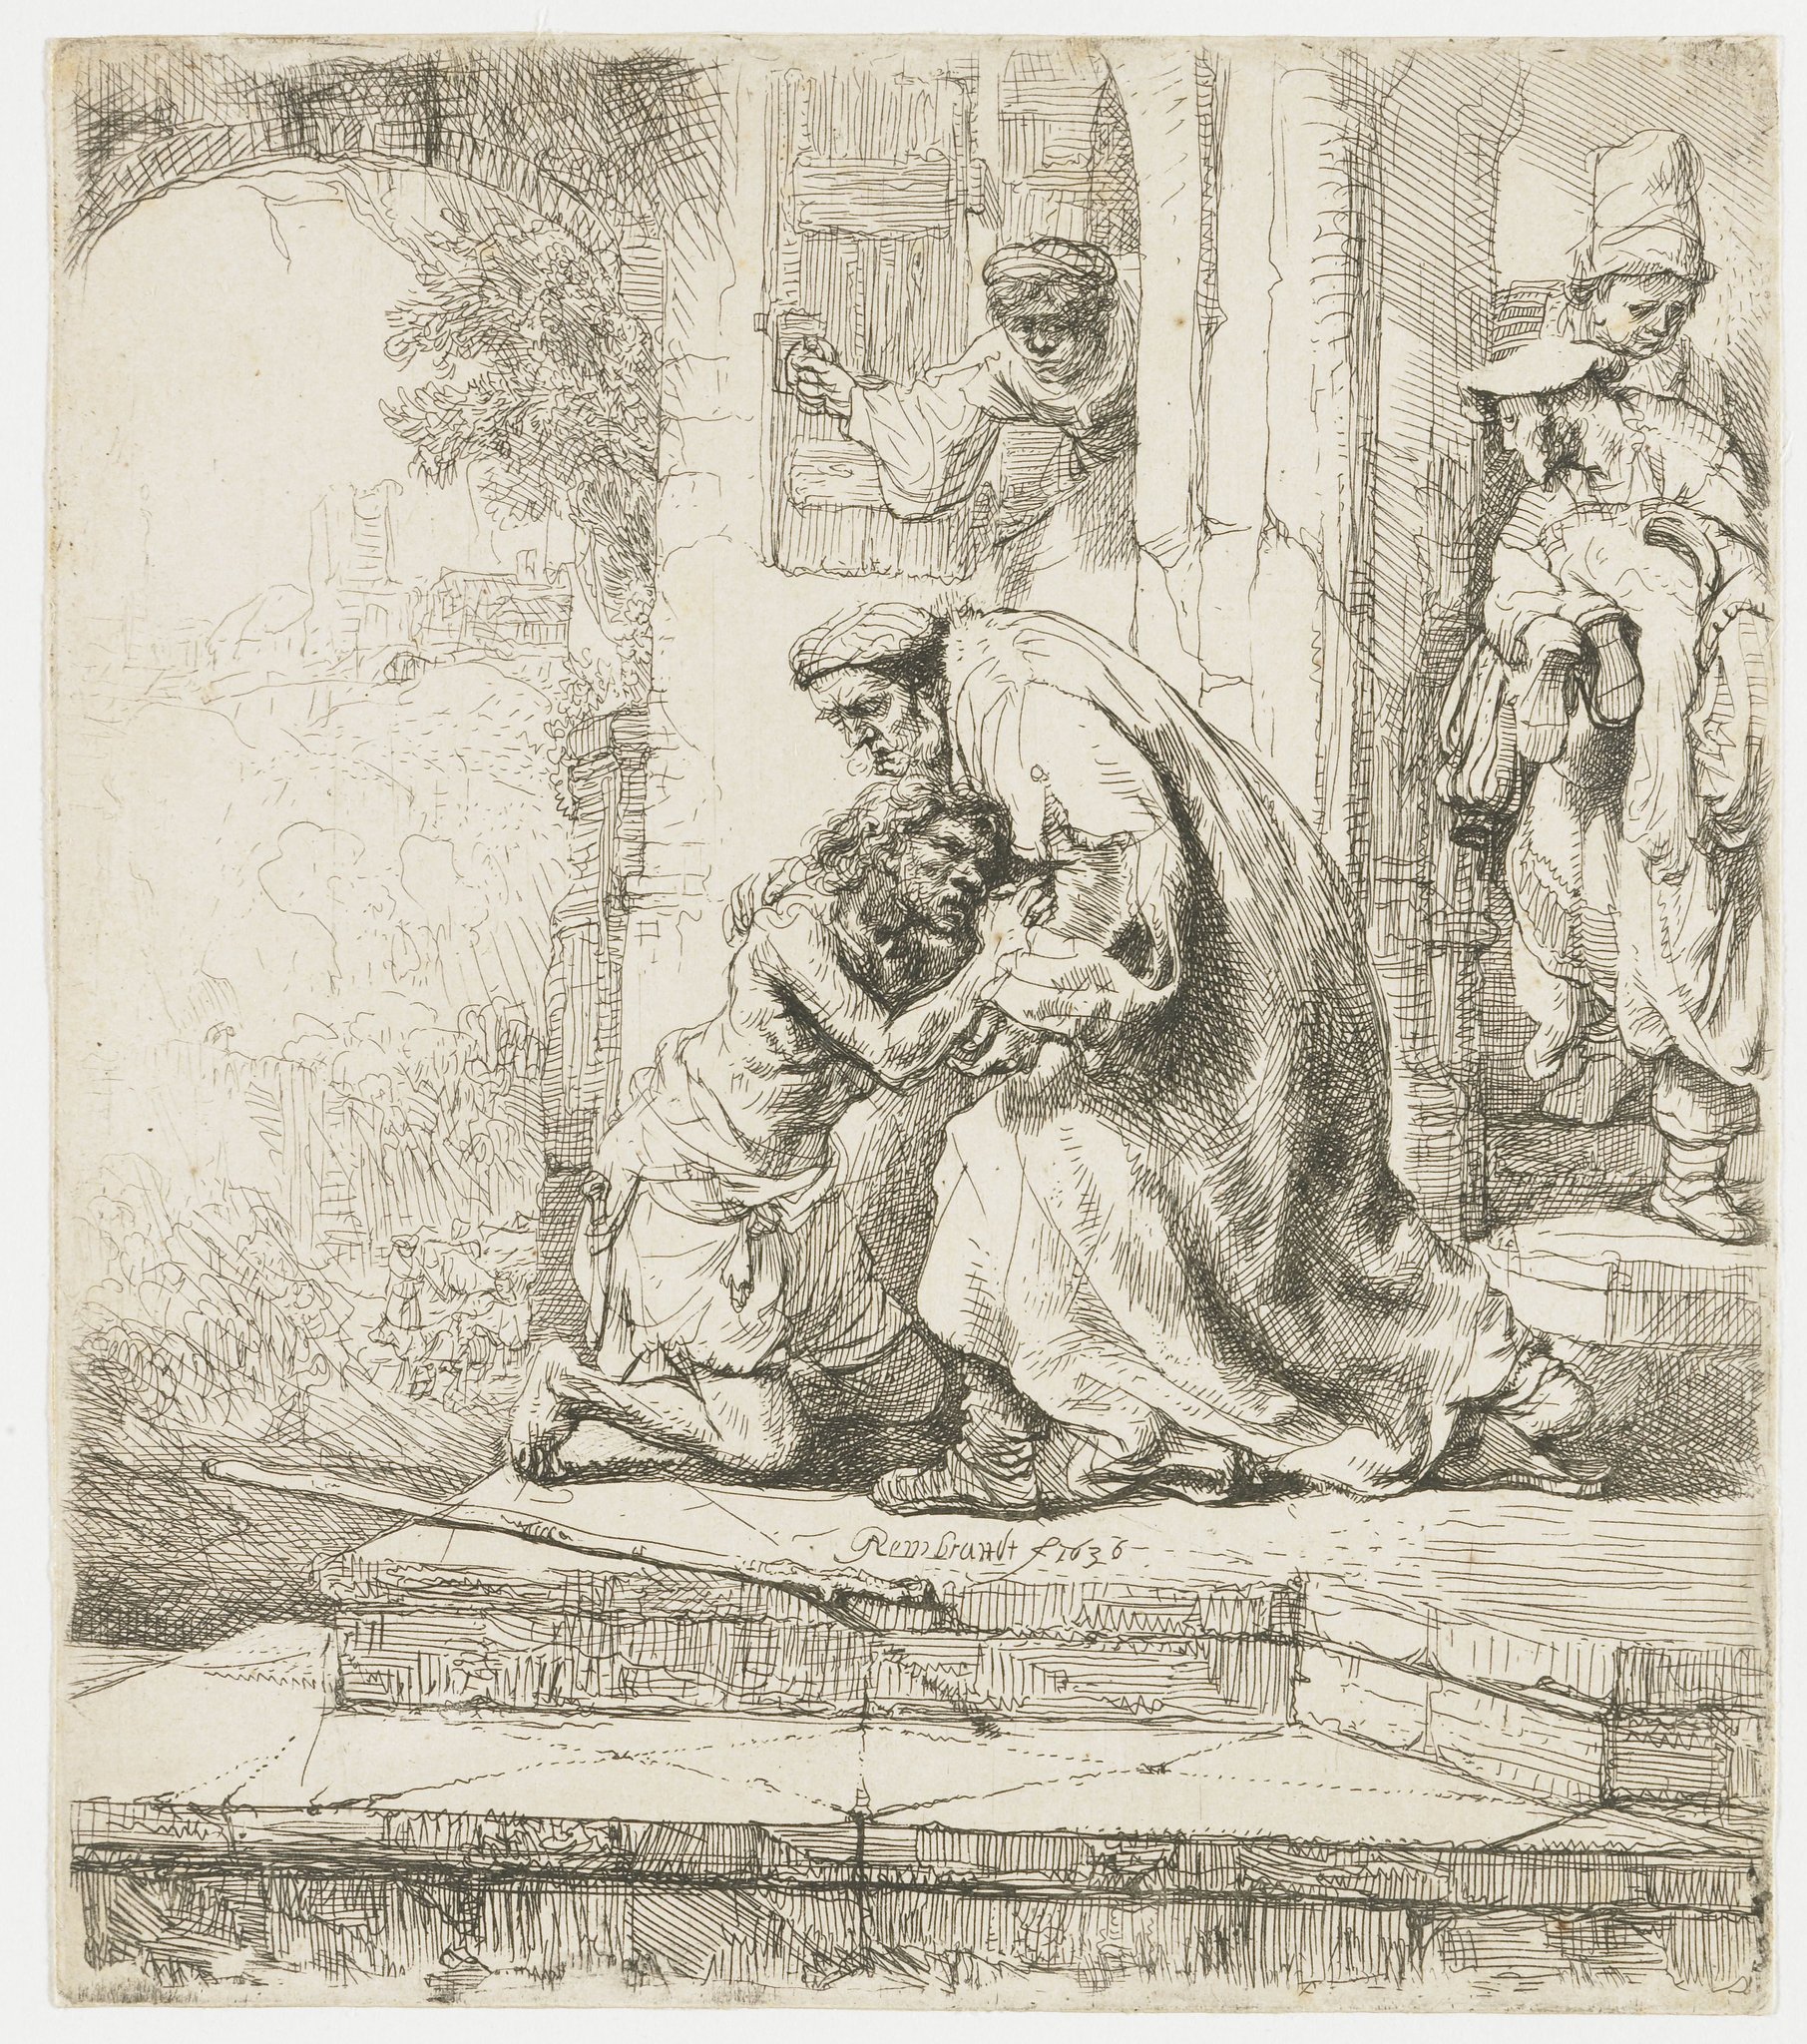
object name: print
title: The Return of the Prodigal Son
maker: rembrandt van rijn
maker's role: draughtsman, painter, print maker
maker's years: 1606-1669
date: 1636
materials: paper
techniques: etching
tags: the parable of the prodigal son (luke 15:11-32)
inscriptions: signature and date: ‘Rembrandt f 1636’, collector's mark: Lugt 240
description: The youngest son of a man demanded his inheritance and then squandered it abroad. Destitute, he returned home and begged his father’s forgiveness. The joyful father organized a festive meal to celebrate the fact that his son had seen the error of his ways. Rembrandt depicts the moment he lovingly receives his son and has fine clothes brought to him.